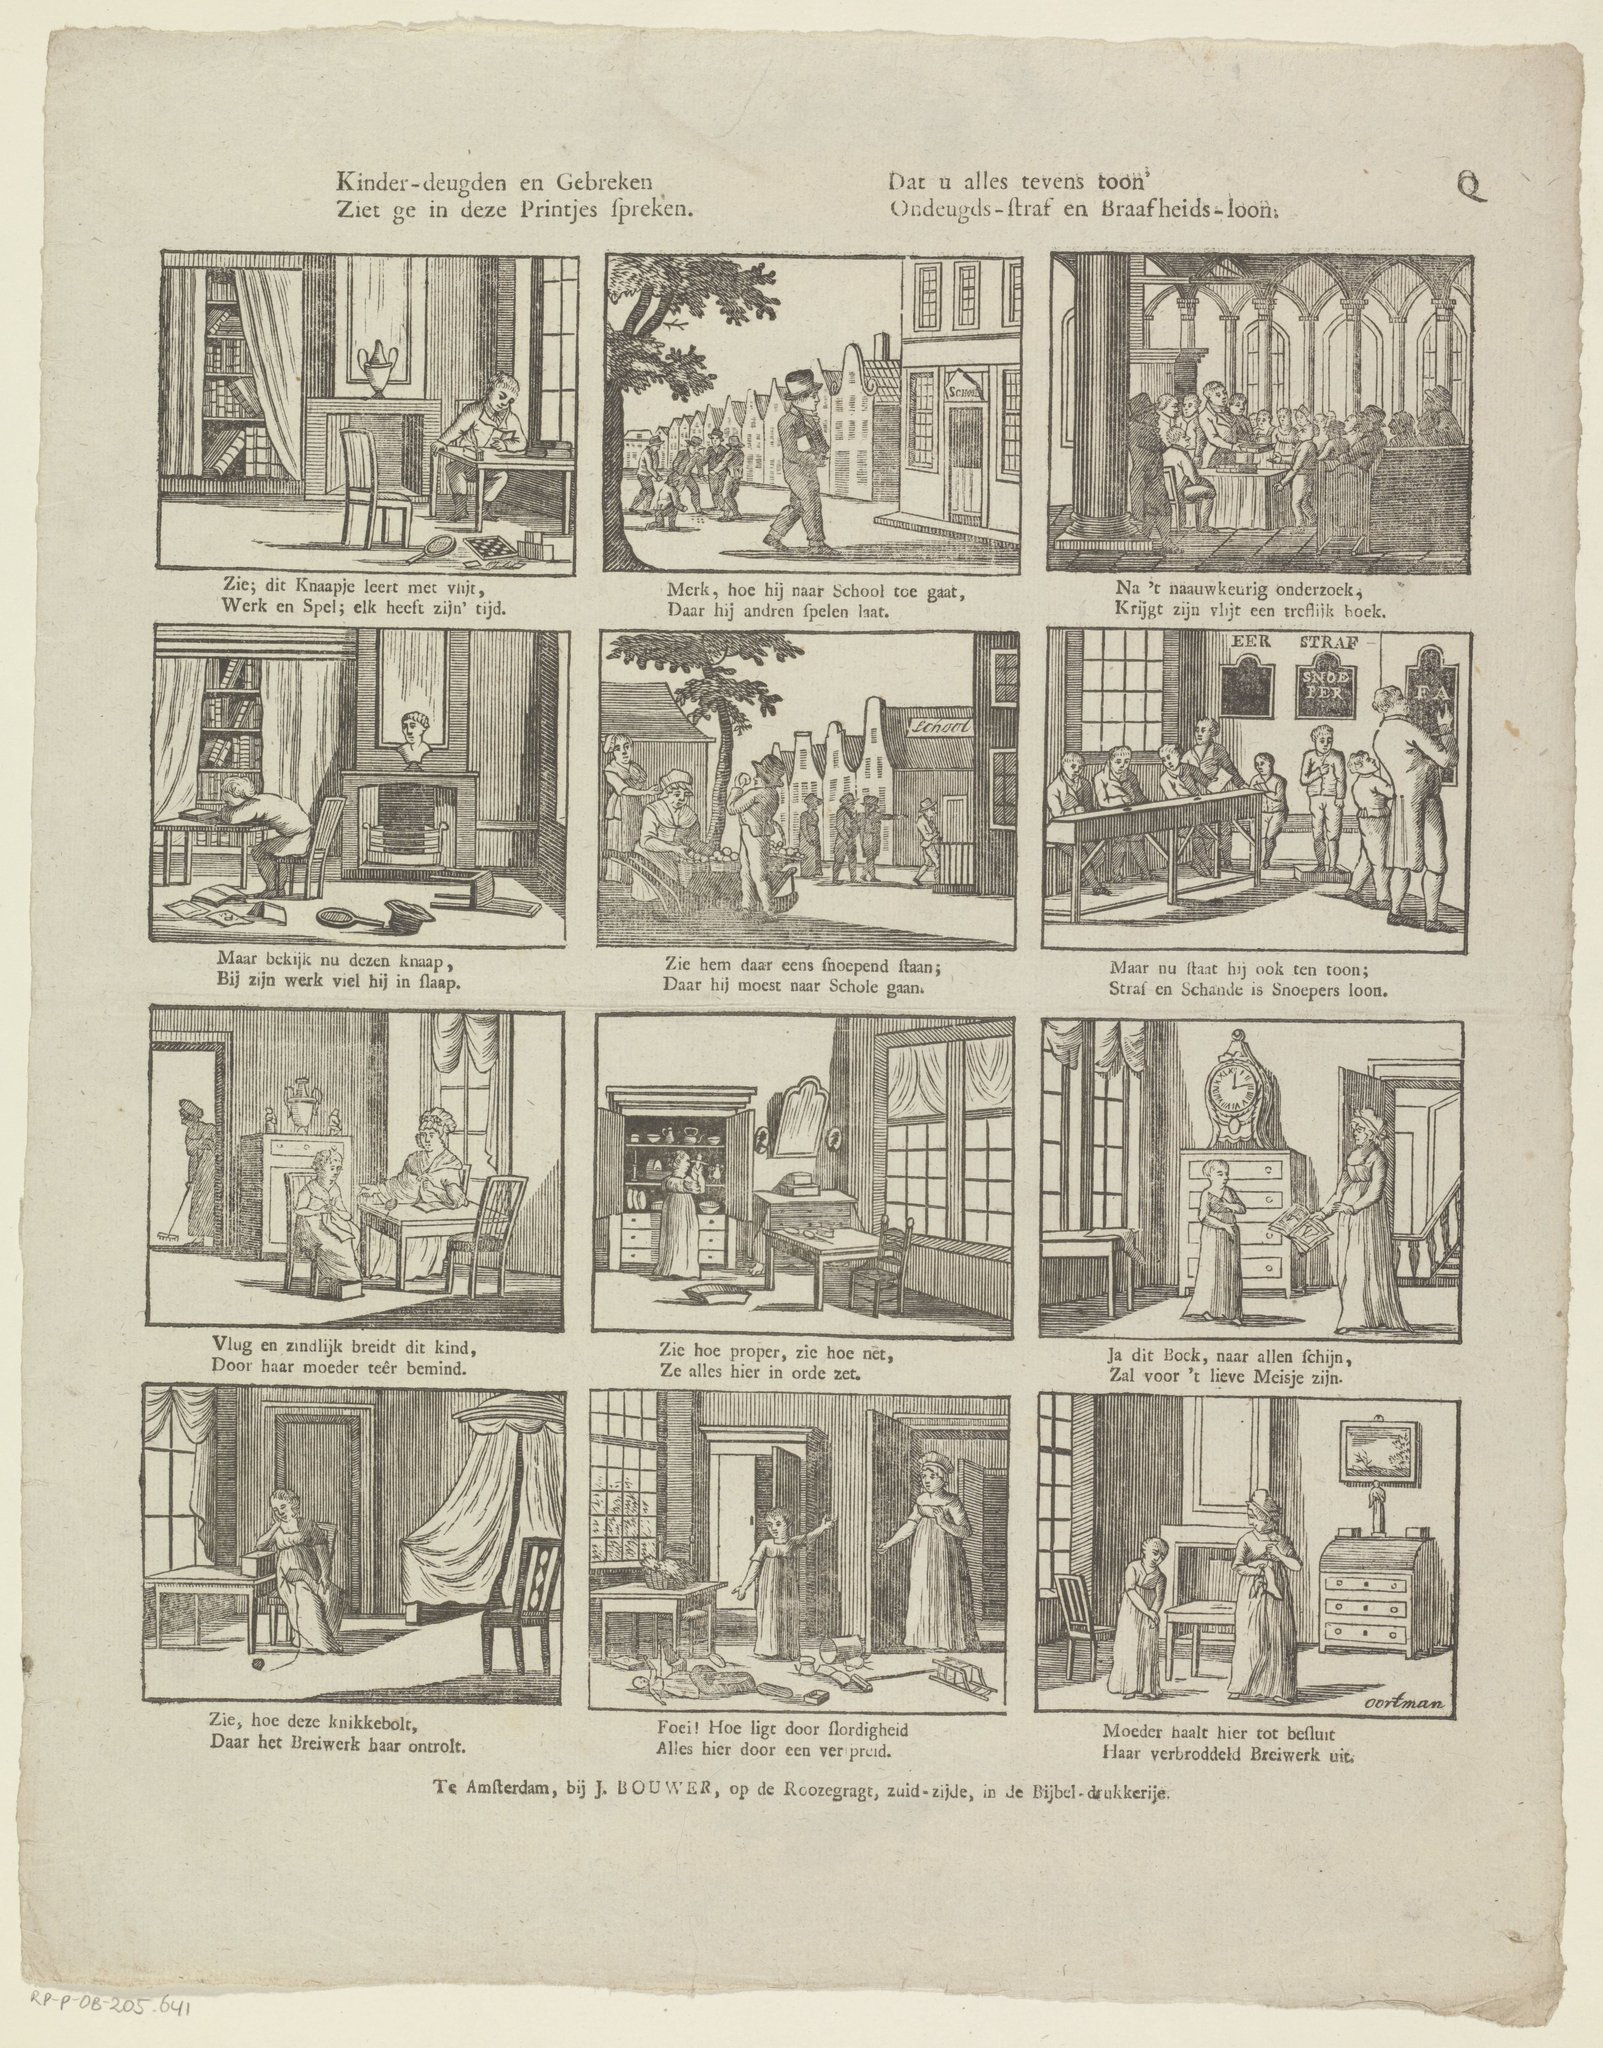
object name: print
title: Kinder-deugden en gebreken / Ziet ge in deze printjes spreken / Dat u alles tevens toon' / Ondeugds-straf en braafheids-loon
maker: johannes bouwer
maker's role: printer, publisher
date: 1805-1808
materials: paper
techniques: letterpress printing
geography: amsterdam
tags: tasks performed by children - aa - girl, bad habits - aa - girl, good and bad behaviour, moral qualities (opposing concepts) (+ situation or event (especially in genre-painting) with symbolical connotation), punishment at school, elementary school; class, form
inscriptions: collector's mark: Lugt 2760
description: Blad met 12 voorstellingen van de beloning van gehoorzame kinderen en de bestraffing van ongehoorzame kinderen. Onder elke afbeelding een tweeregelig vers. Genummerd rechtsboven: Q.